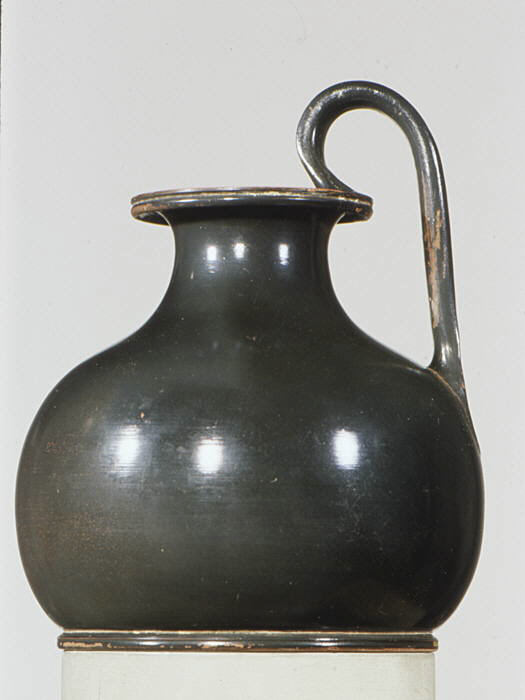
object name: oinochoe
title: Terracotta oinochoe (jug)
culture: greek, attic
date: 500-401 BCE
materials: terracotta